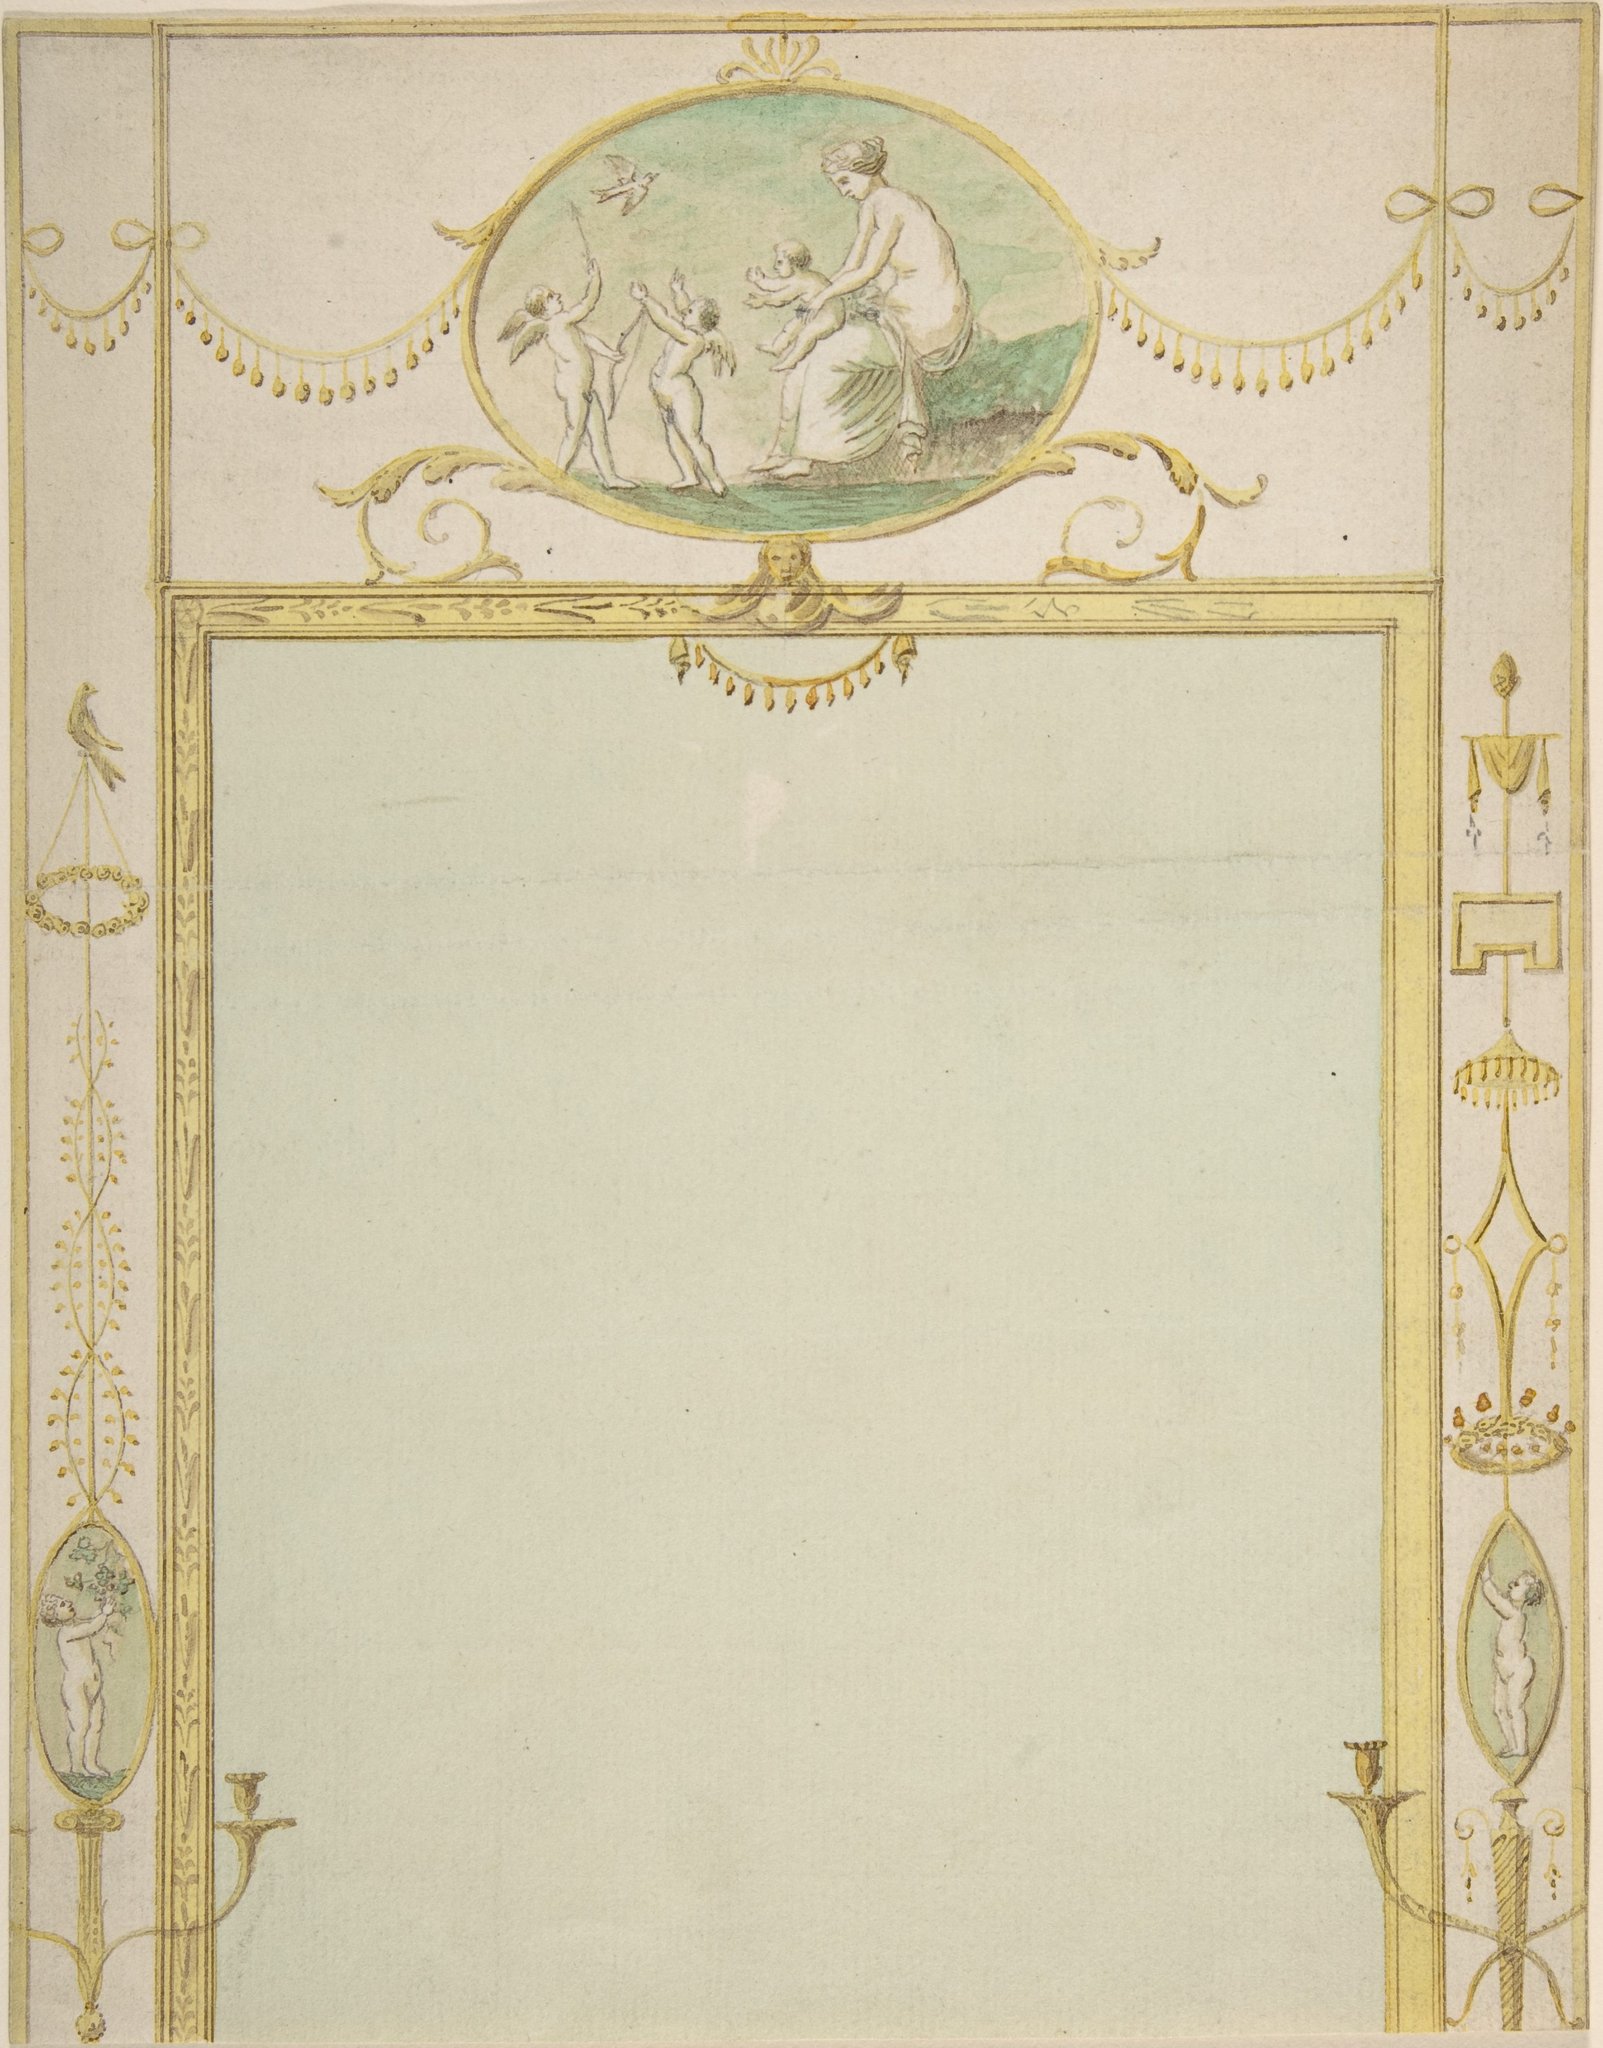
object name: drawing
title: Design for a Mirror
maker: james wyatt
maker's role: artist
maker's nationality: british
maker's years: 1746-1813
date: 1734-1833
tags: mirrors